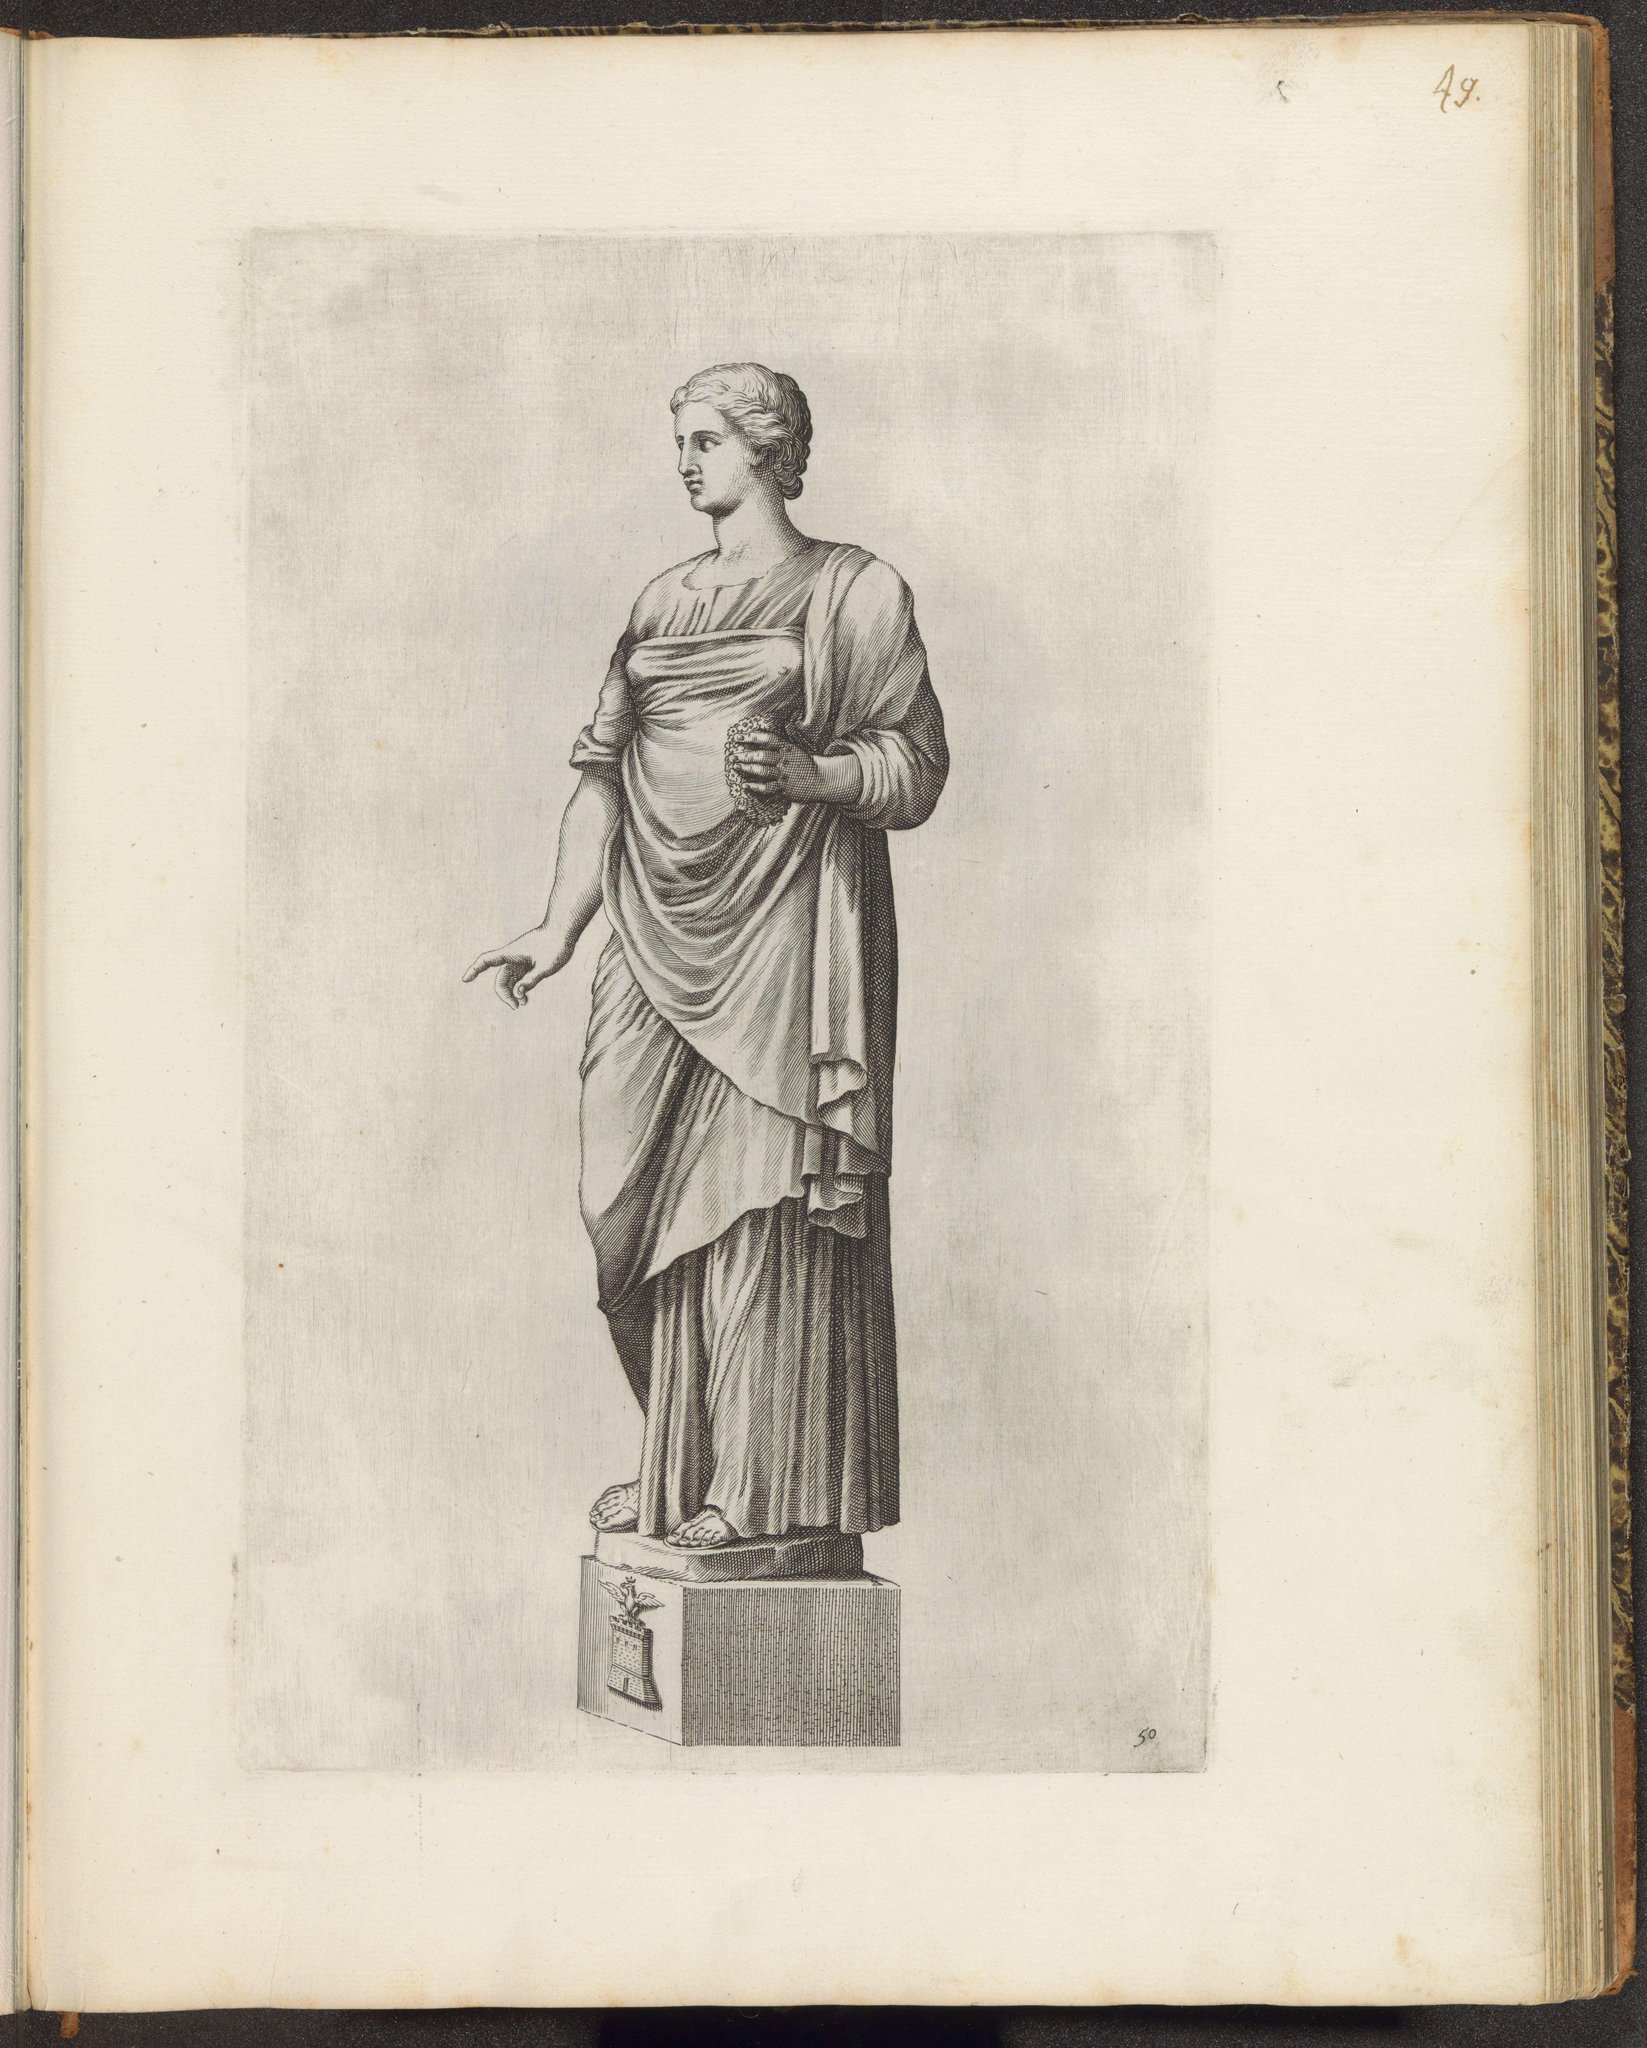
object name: print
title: Standbeeld van Flora met bloemen in de hand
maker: luca ciamberlano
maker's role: painter, print maker, publisher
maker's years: 1570-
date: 1636-1647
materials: paper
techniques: engraving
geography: rome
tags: piece of sculpture, reproduction of a piece of sculpture, (story of) flora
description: Standbeeld van Flora met bloemen in de hand. Ze wijst met haar rechterhand. Op de basis het wapenschild van Vincenzo Giustiniani. Prent maakt deel uit van een album met een serie prenten naar de sculpturen in de verzameling in de Galleria Giustiniani te Rome.